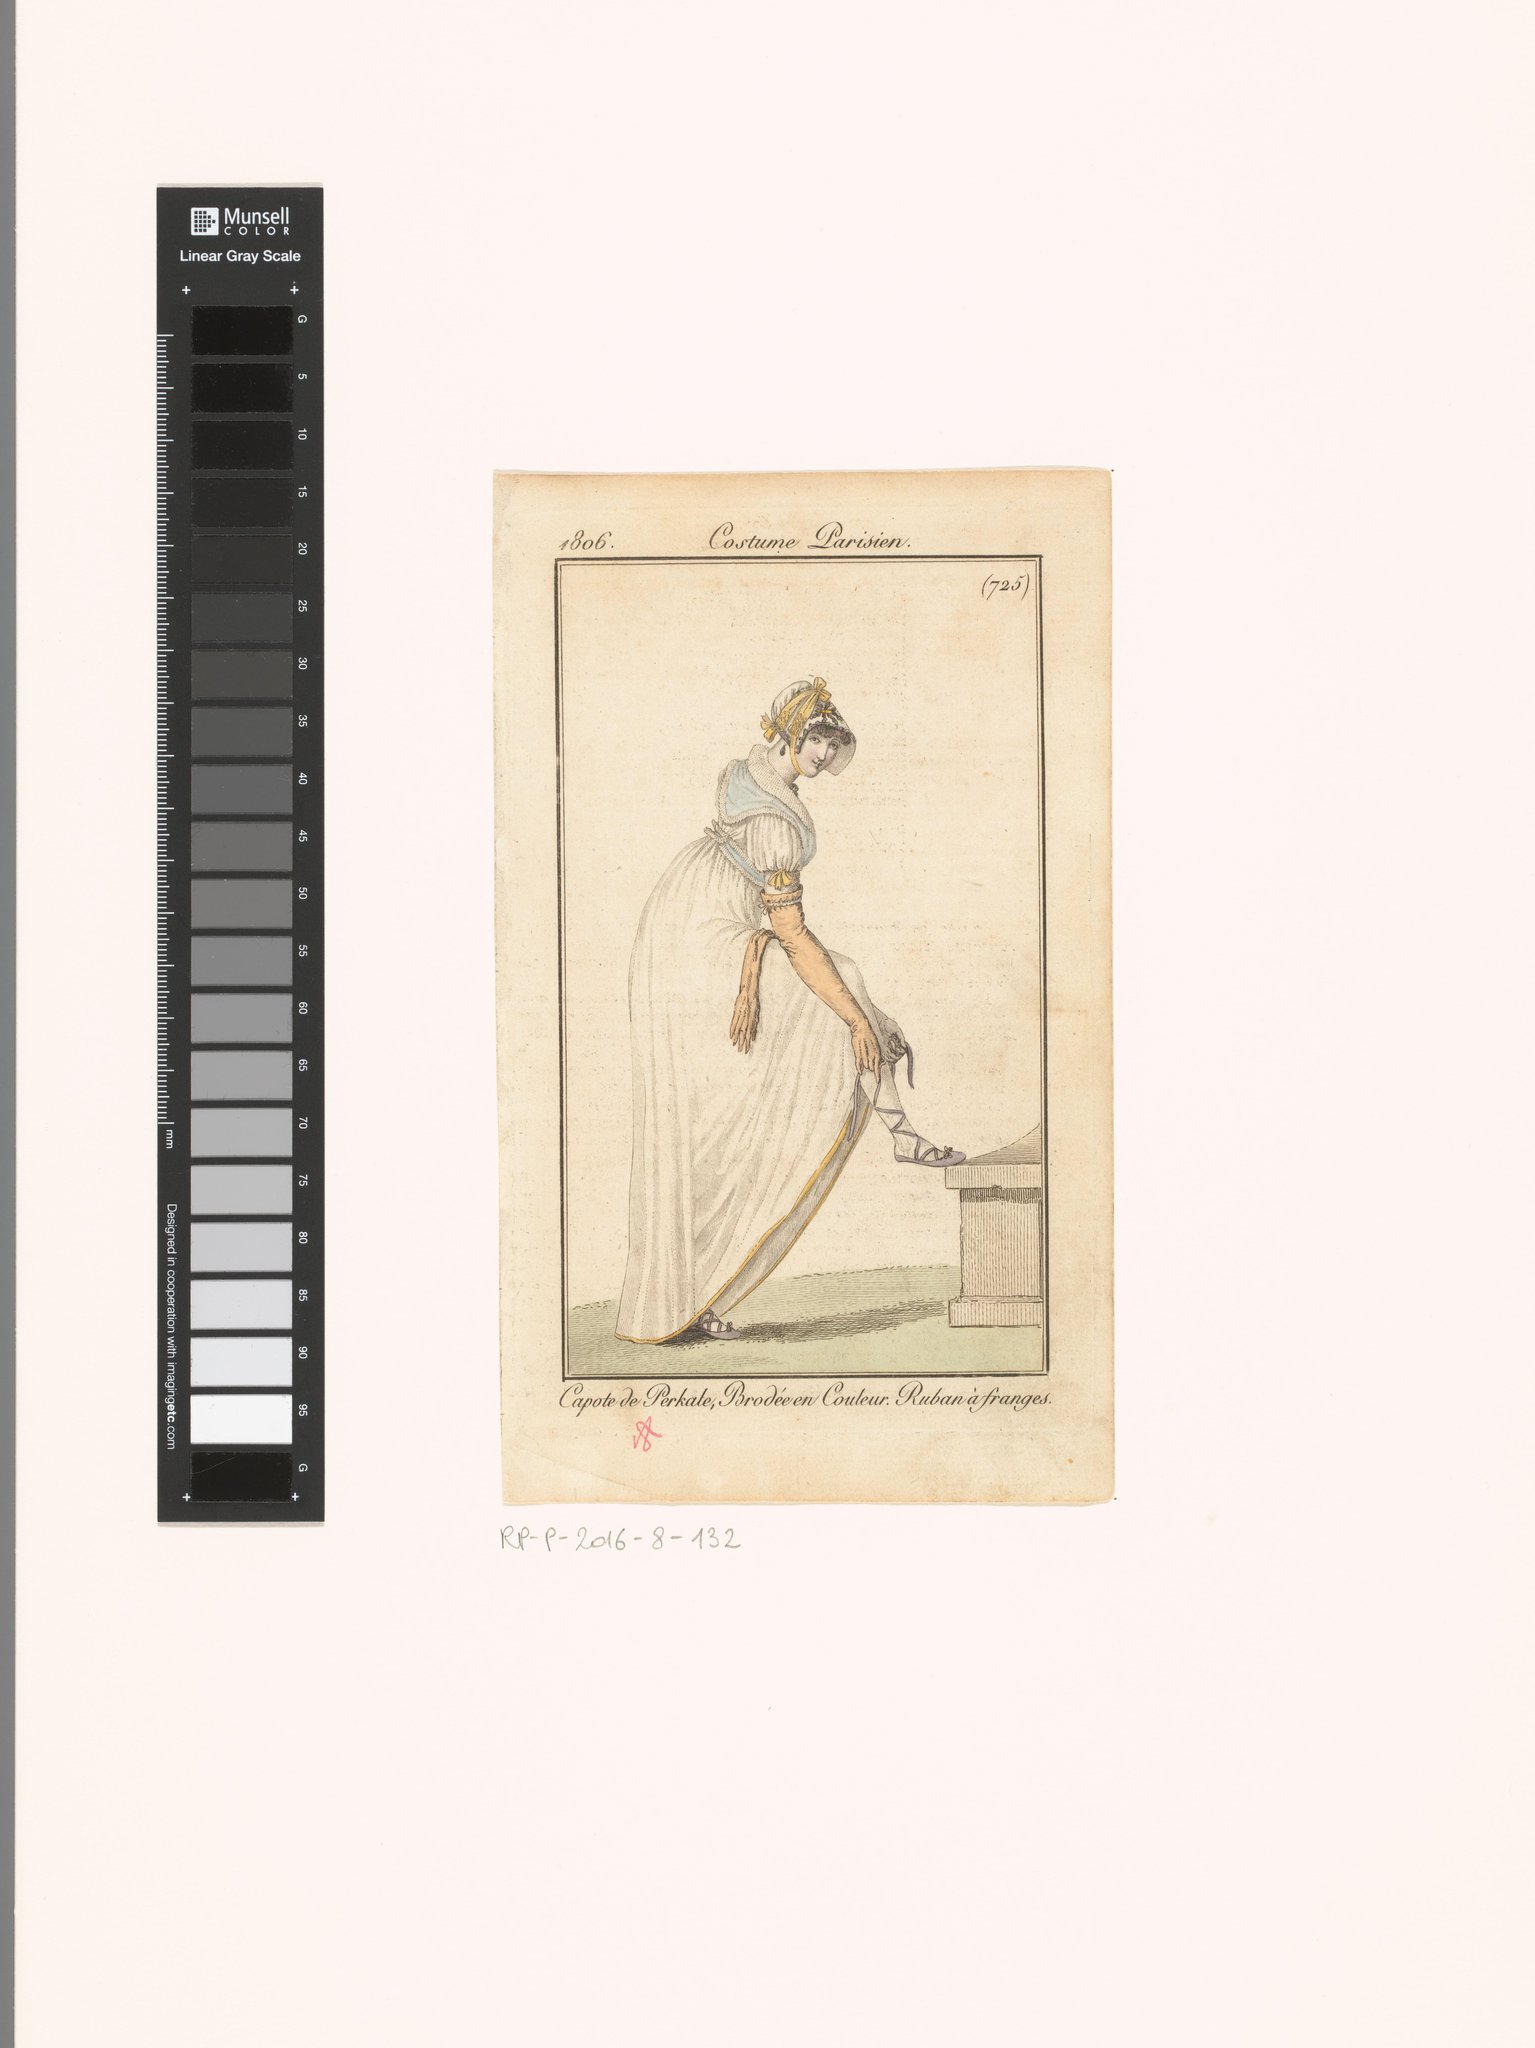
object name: fashion print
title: Journal des Dames et des modes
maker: Anonymous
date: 1806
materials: paper, ink, watercolor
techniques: etching, hand coloring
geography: france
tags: fashion plates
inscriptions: collector's mark: Lugt 2228